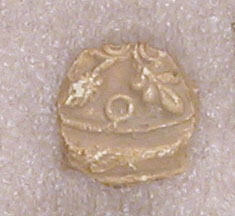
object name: fragment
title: Ceramic Fragment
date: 701-900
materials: earthenware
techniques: molding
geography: iraq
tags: leaves